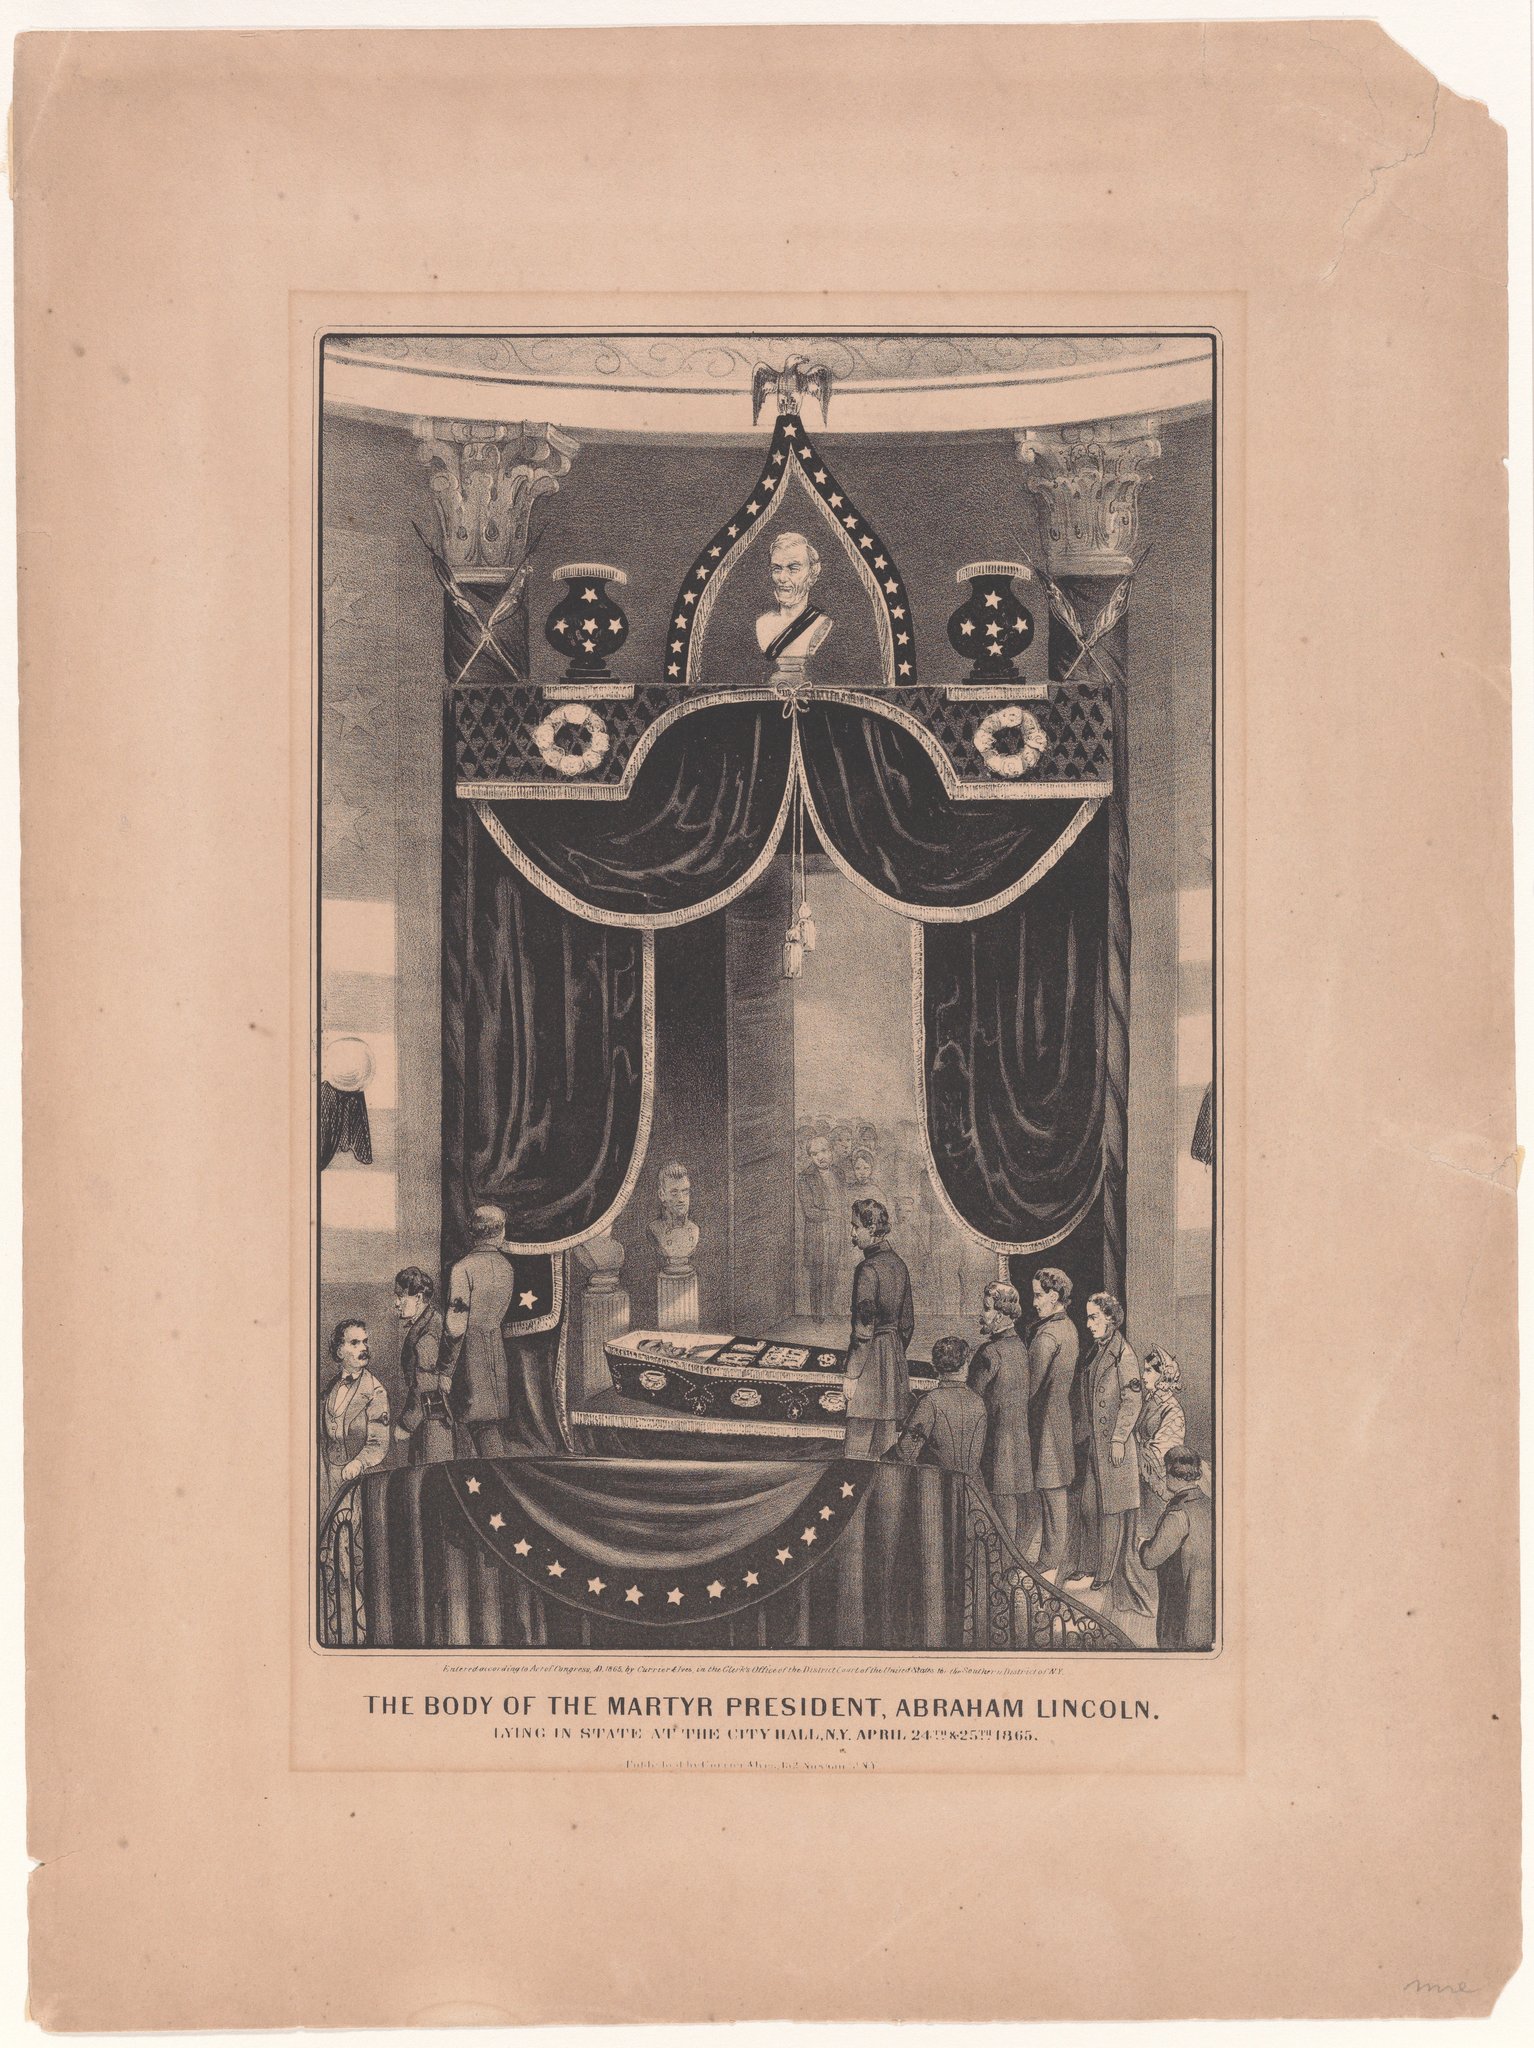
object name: print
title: The Body of the Martyr President, Abraham Lincoln, Lying in State at the City Hall, N.Y., April 24th & 25th, 1865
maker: currier & ives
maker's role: publisher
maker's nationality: american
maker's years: 1857-1907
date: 1865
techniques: lithograph